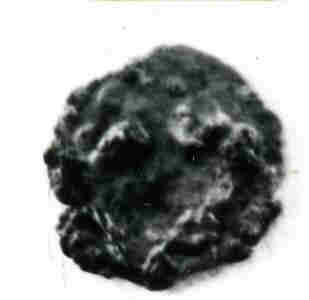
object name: coin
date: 401-1400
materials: copper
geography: iran